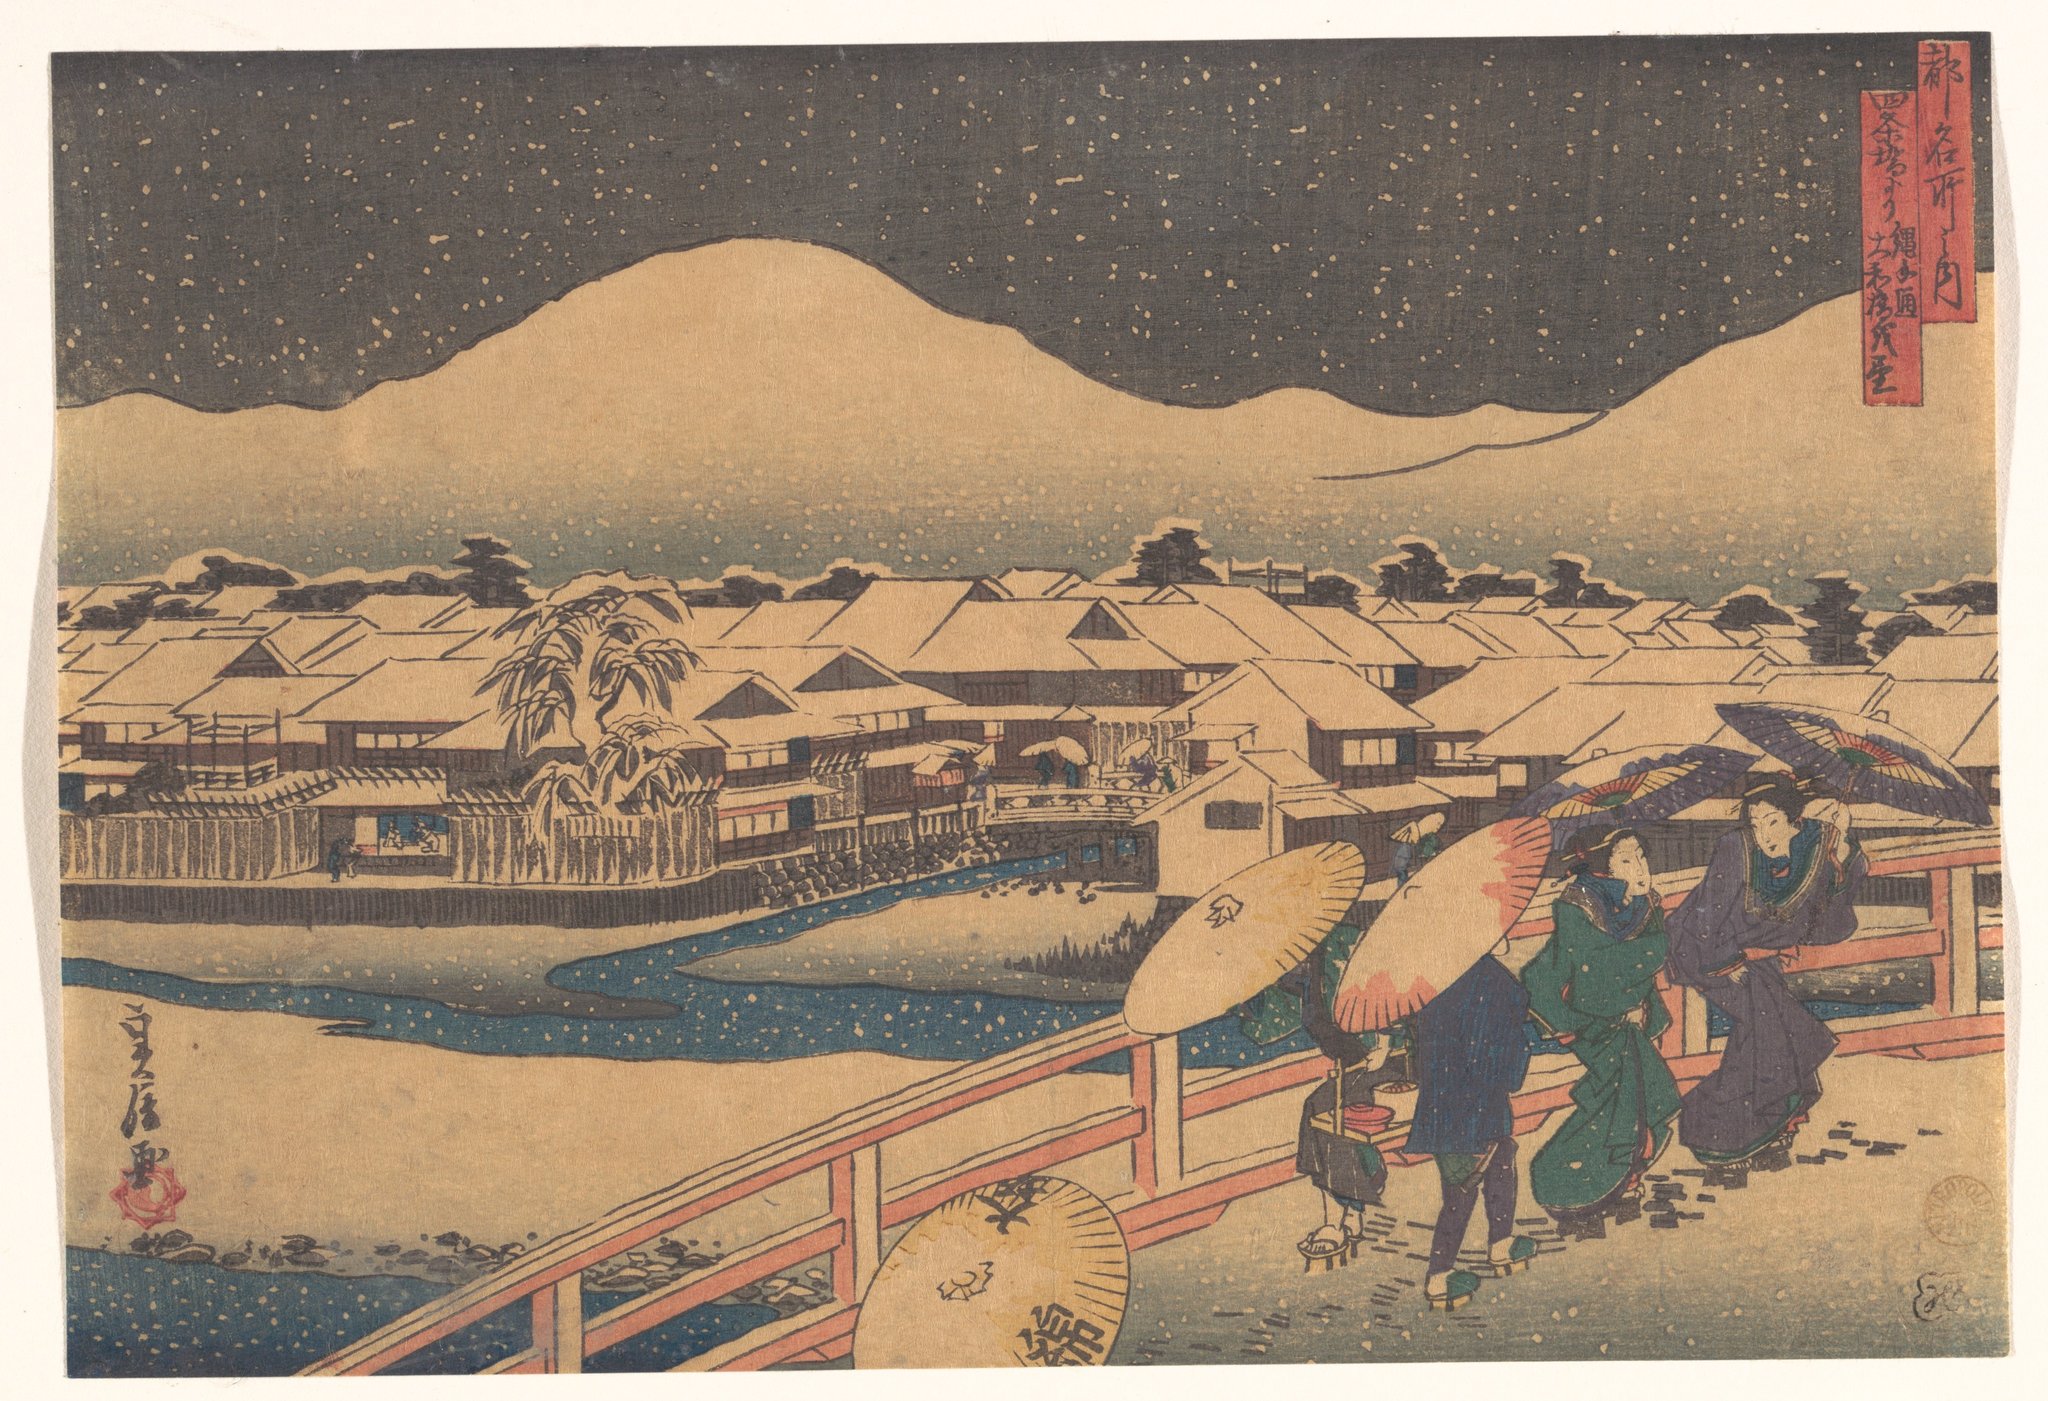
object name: print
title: Night View of the Yamato Tea-house in Nawate Dori Seen from Shijo Bridge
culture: japanese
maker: hasegawa sadanobu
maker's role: artist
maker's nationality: japanese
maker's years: 1809-1879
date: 1836-1870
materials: ink, paper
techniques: woodblock print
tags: houses,women,landscapes,night,snow